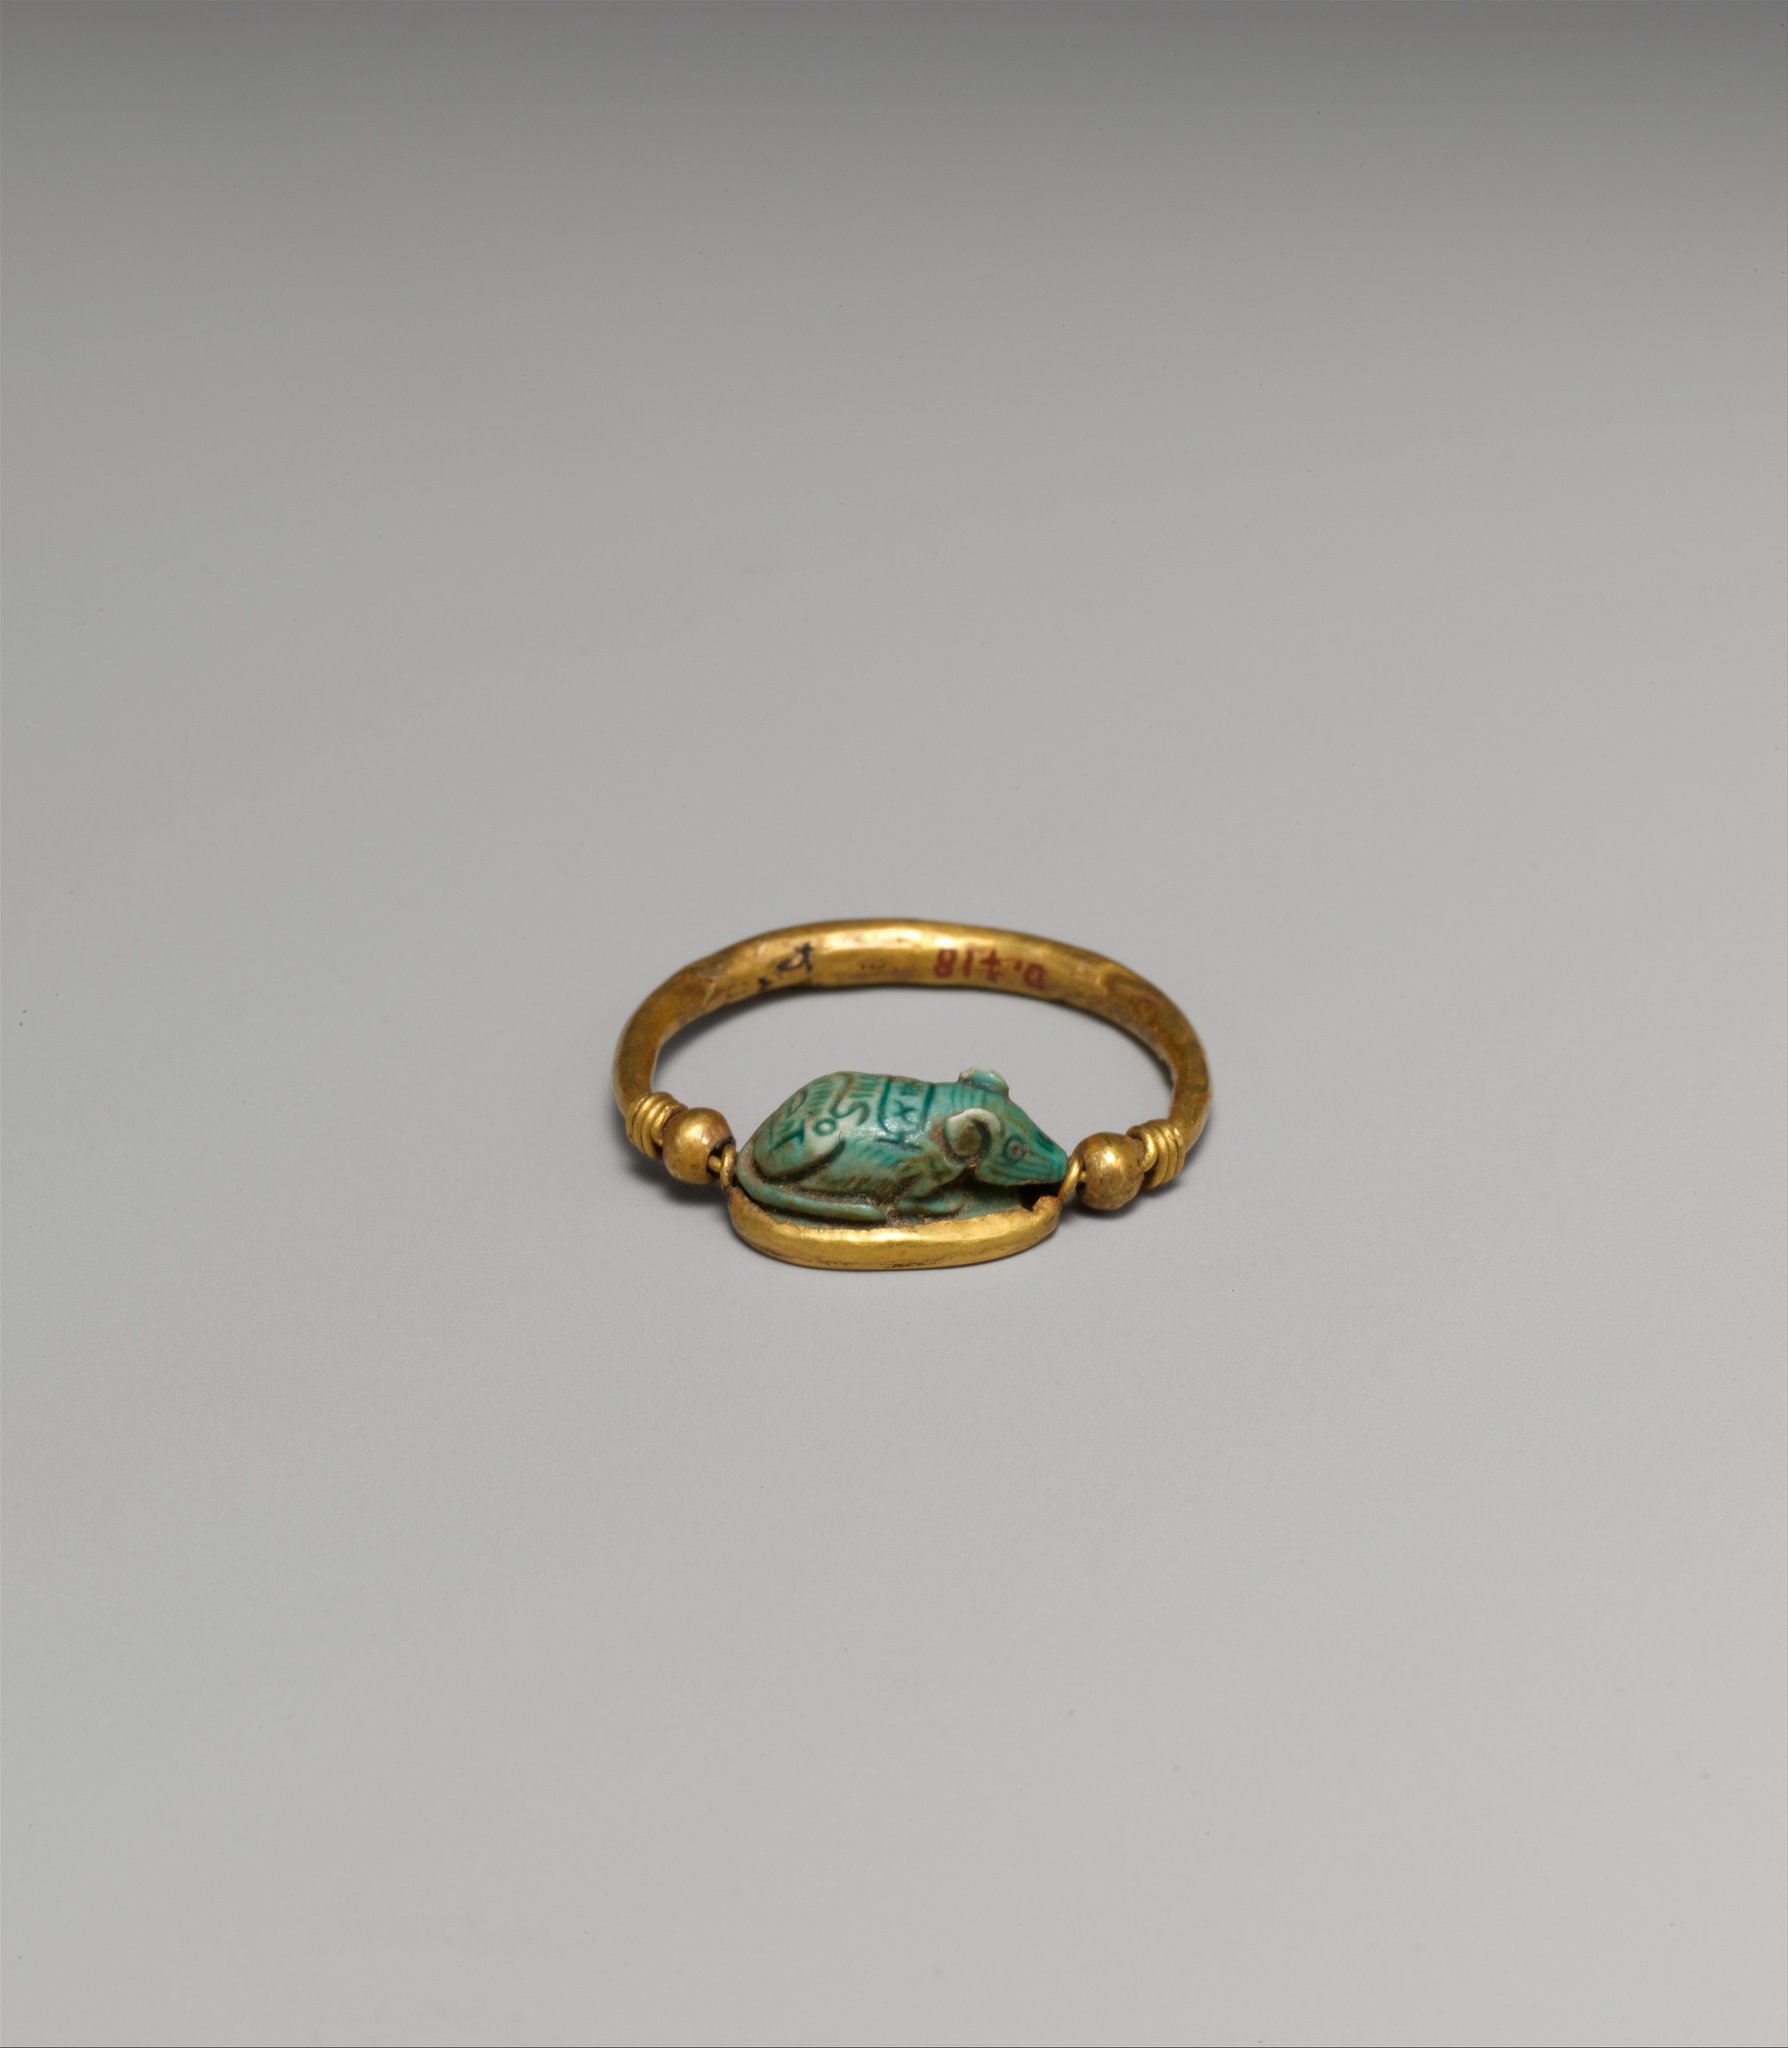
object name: ring, thutmose iii, mouse amulet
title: Ring set with a mouse design amulet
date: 1479-1425 BCE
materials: gold, stone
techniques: glazing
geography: egypt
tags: cartouches,mice